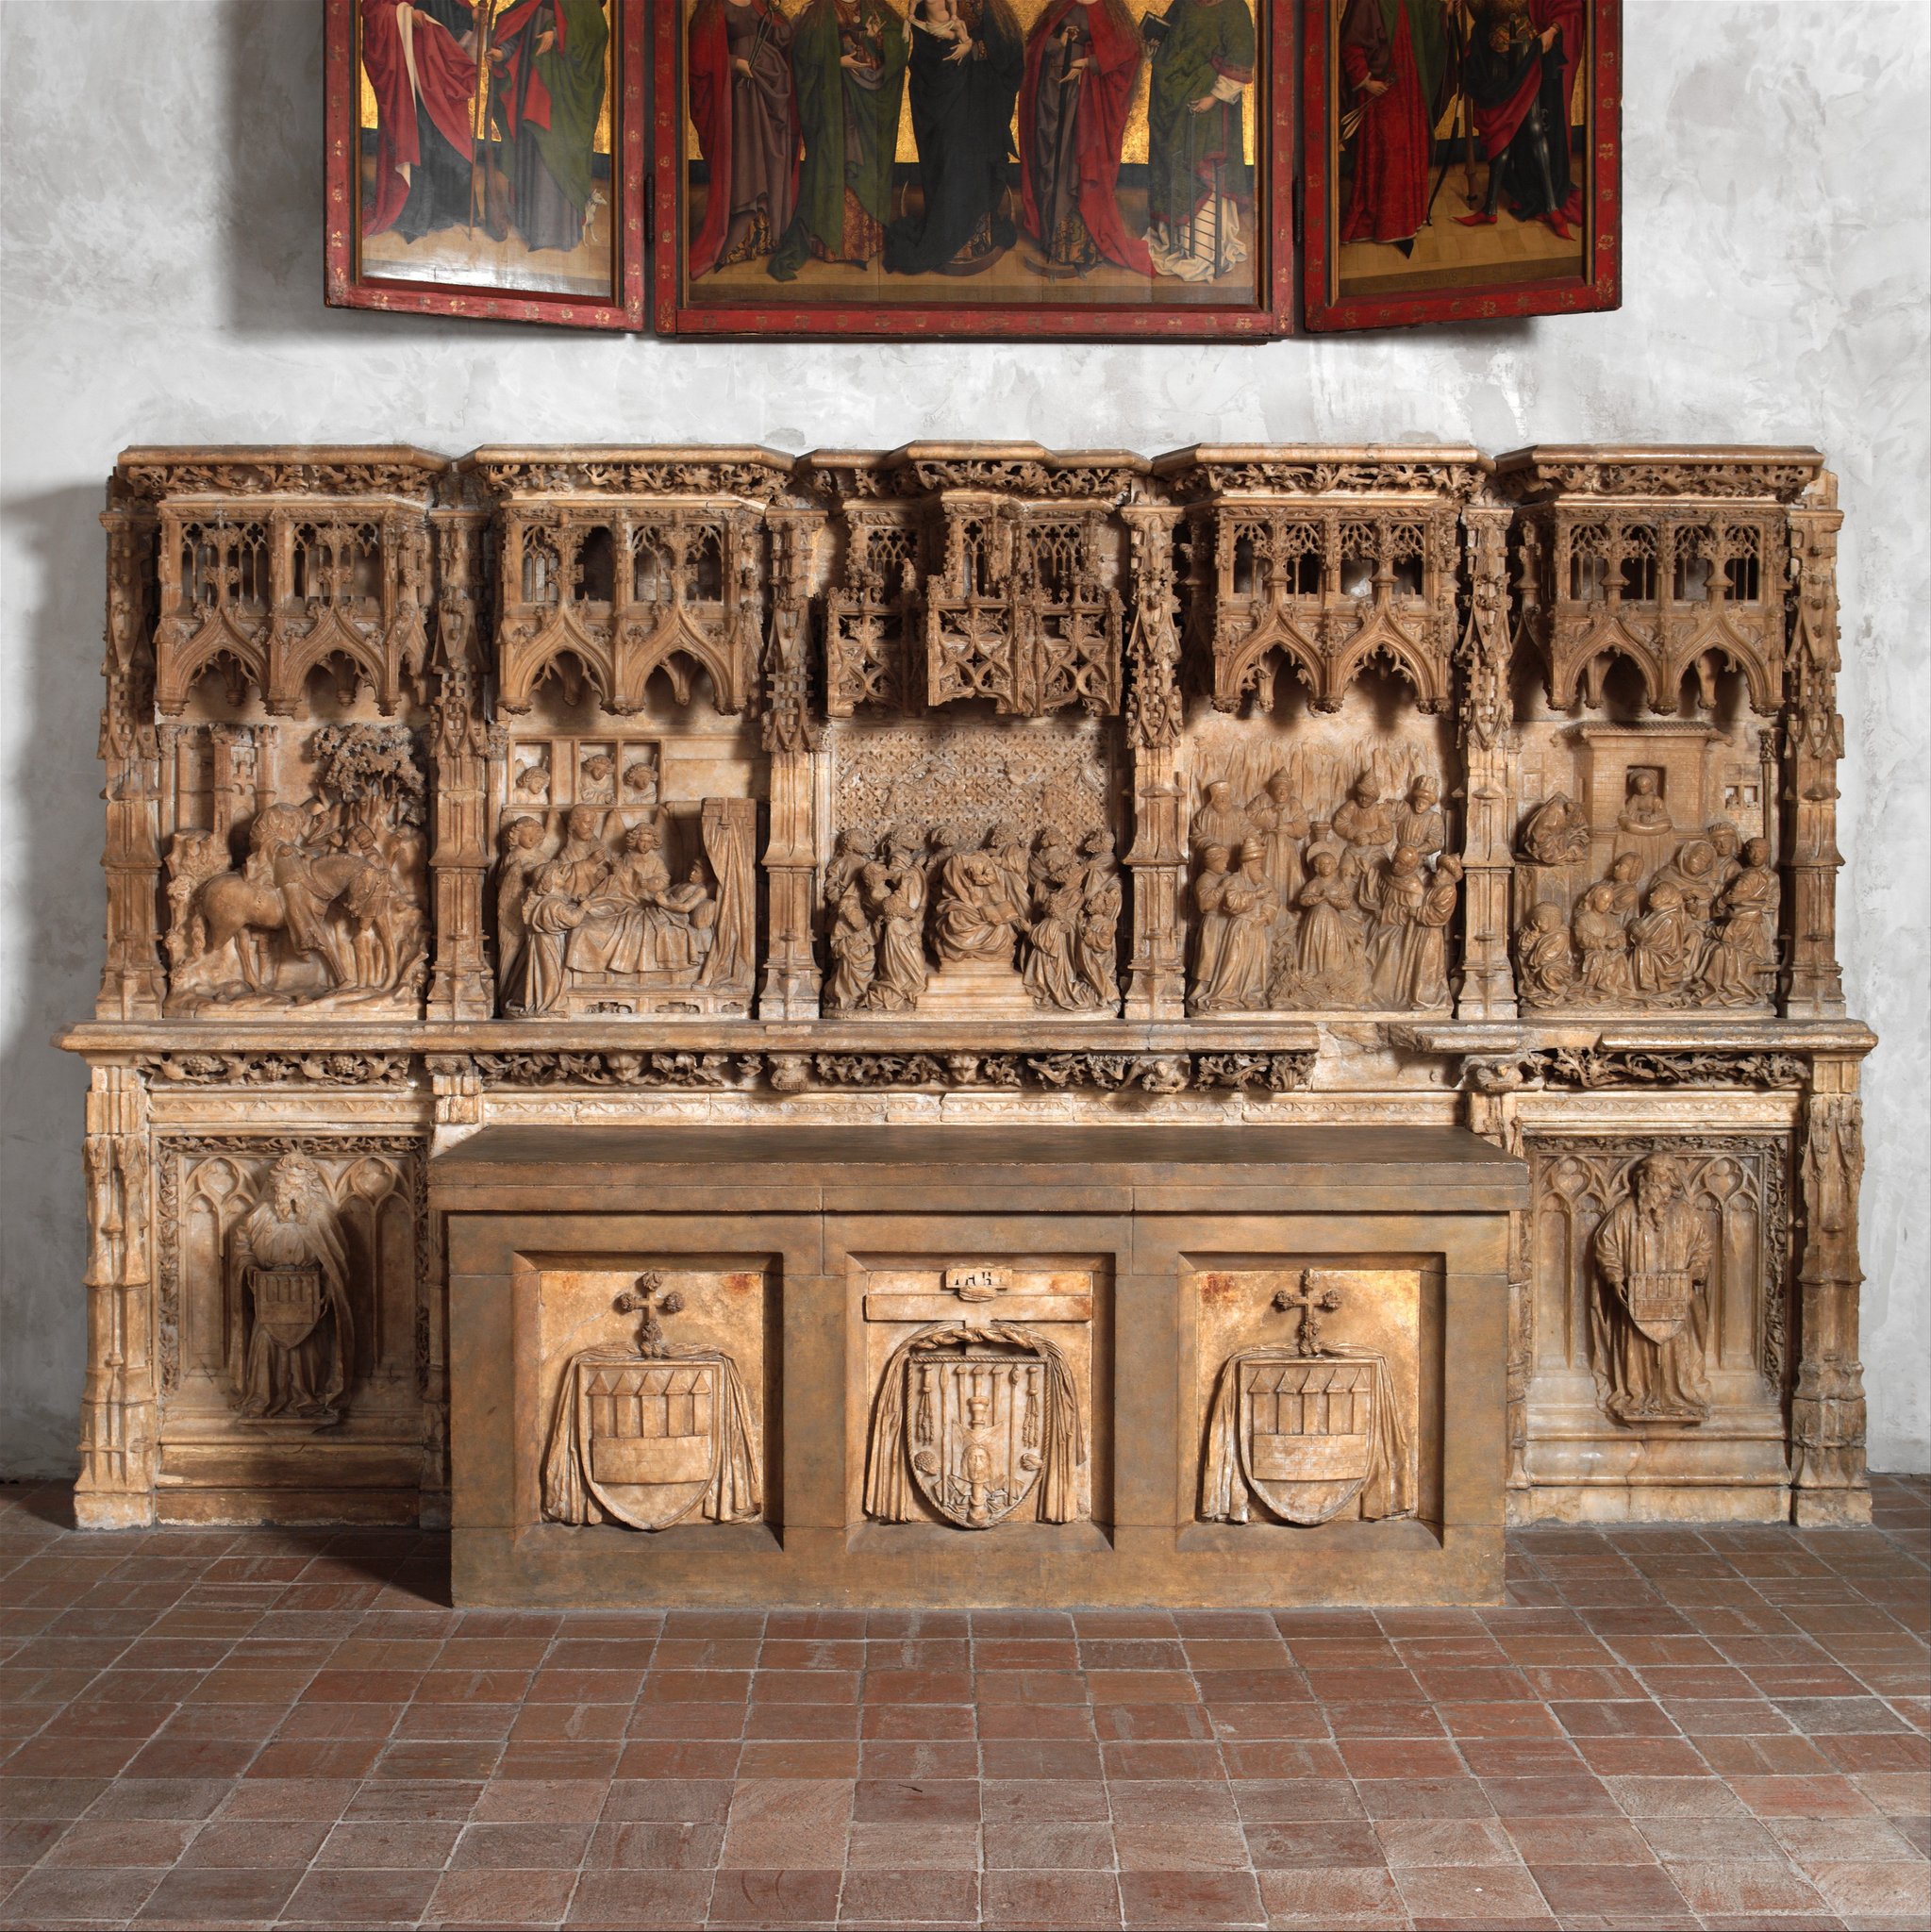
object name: altarpiece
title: Altar Predella and Socle of Archbishop Don Dalmau de Mur y Cervelló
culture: spanish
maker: francí gomar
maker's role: artist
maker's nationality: spanish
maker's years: 1443-1493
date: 1456-1458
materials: alabaster, paint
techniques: gilding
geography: spain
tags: apostles,virgin mary,saints